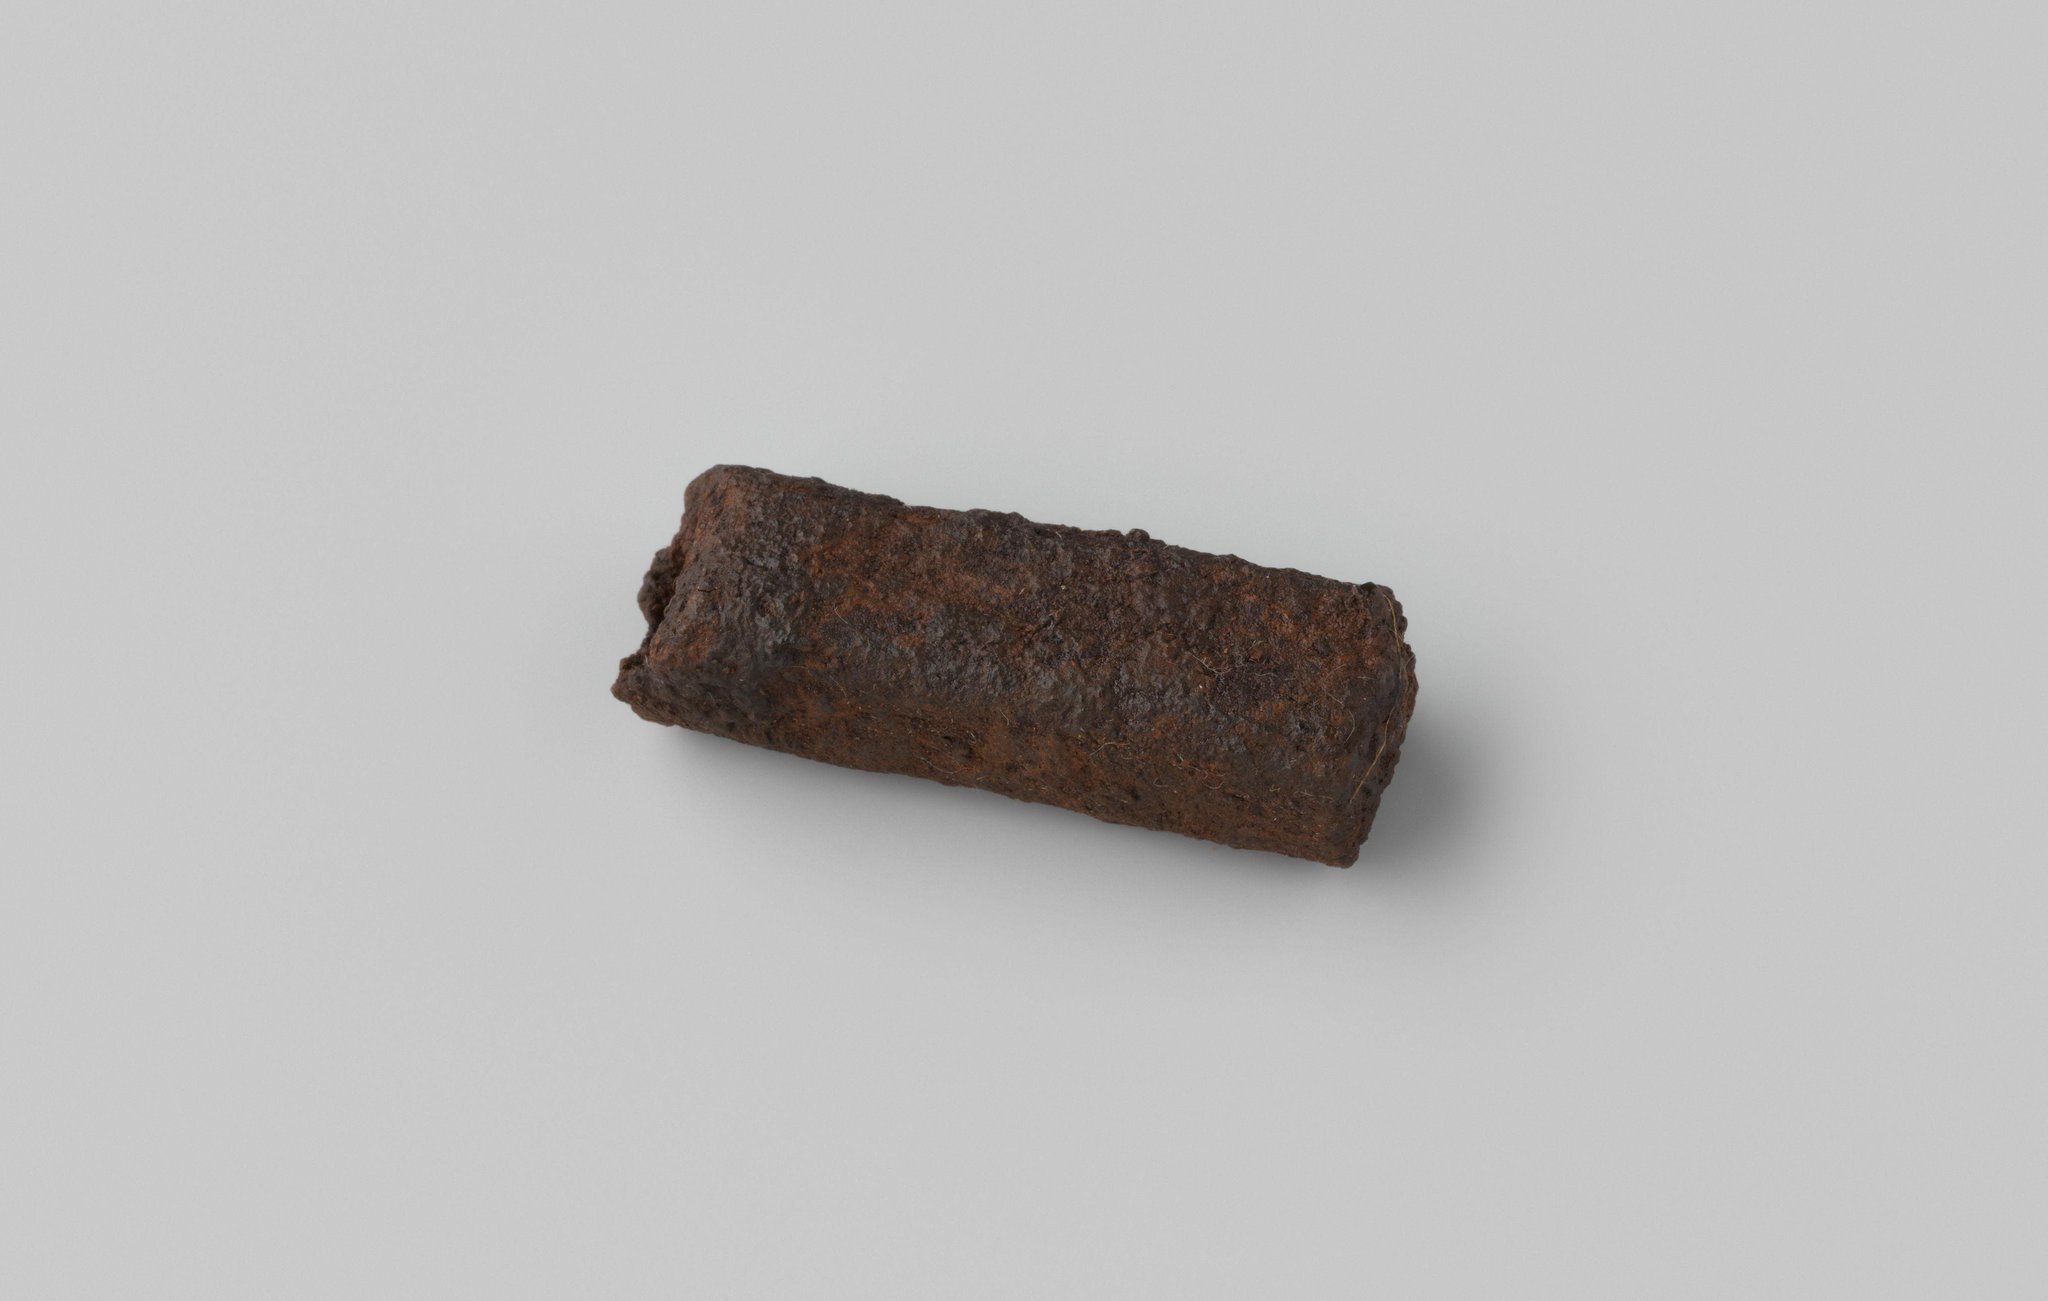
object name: artifact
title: Artefact van ijzer uit het wrak van de Oost-Indiëvaarder Hollandia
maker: Anonymous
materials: iron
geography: netherlands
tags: verenigde oostindische compagnie, hollandia (schip), annet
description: Varied parts or fragments, bar(-shaped) fragments; fragm, eroded, broken: octagonal in section (oblique corners).